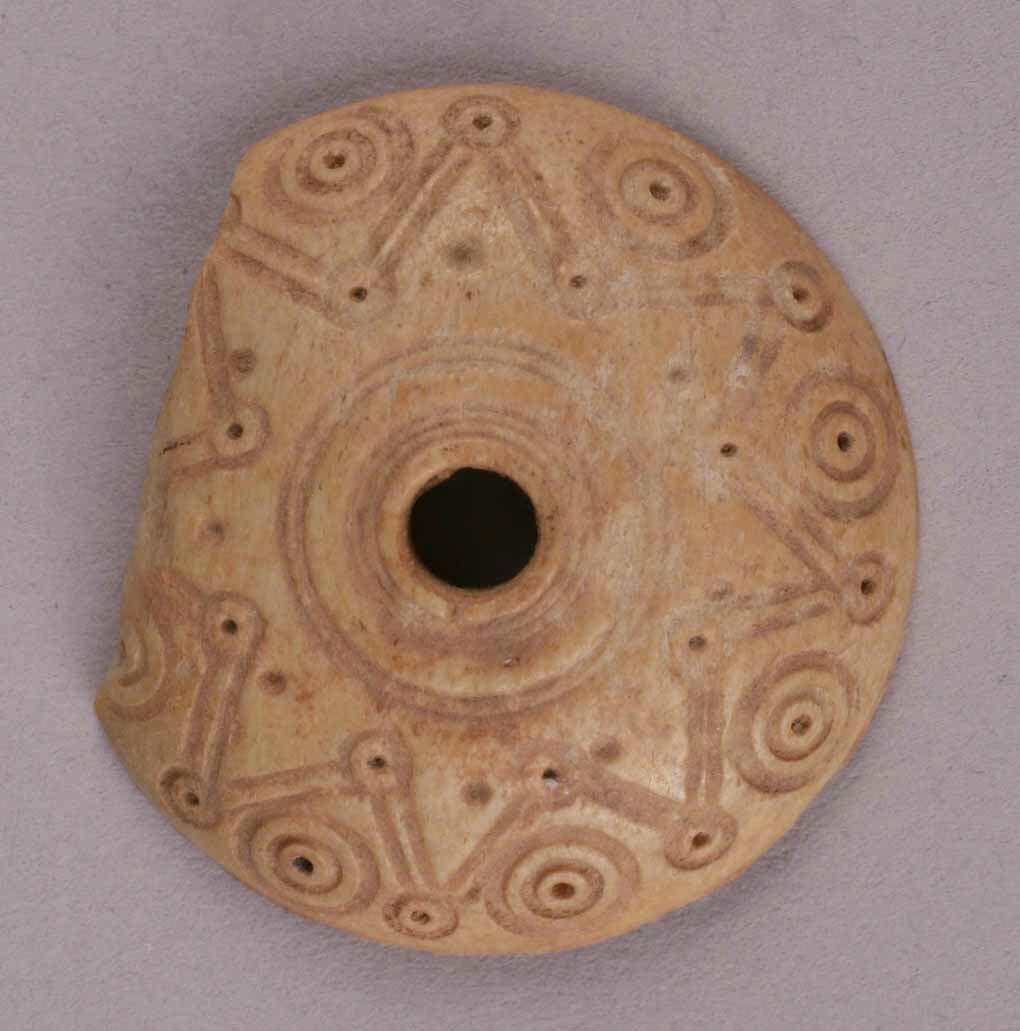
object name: button or bead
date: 801-1000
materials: bone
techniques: incising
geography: iran